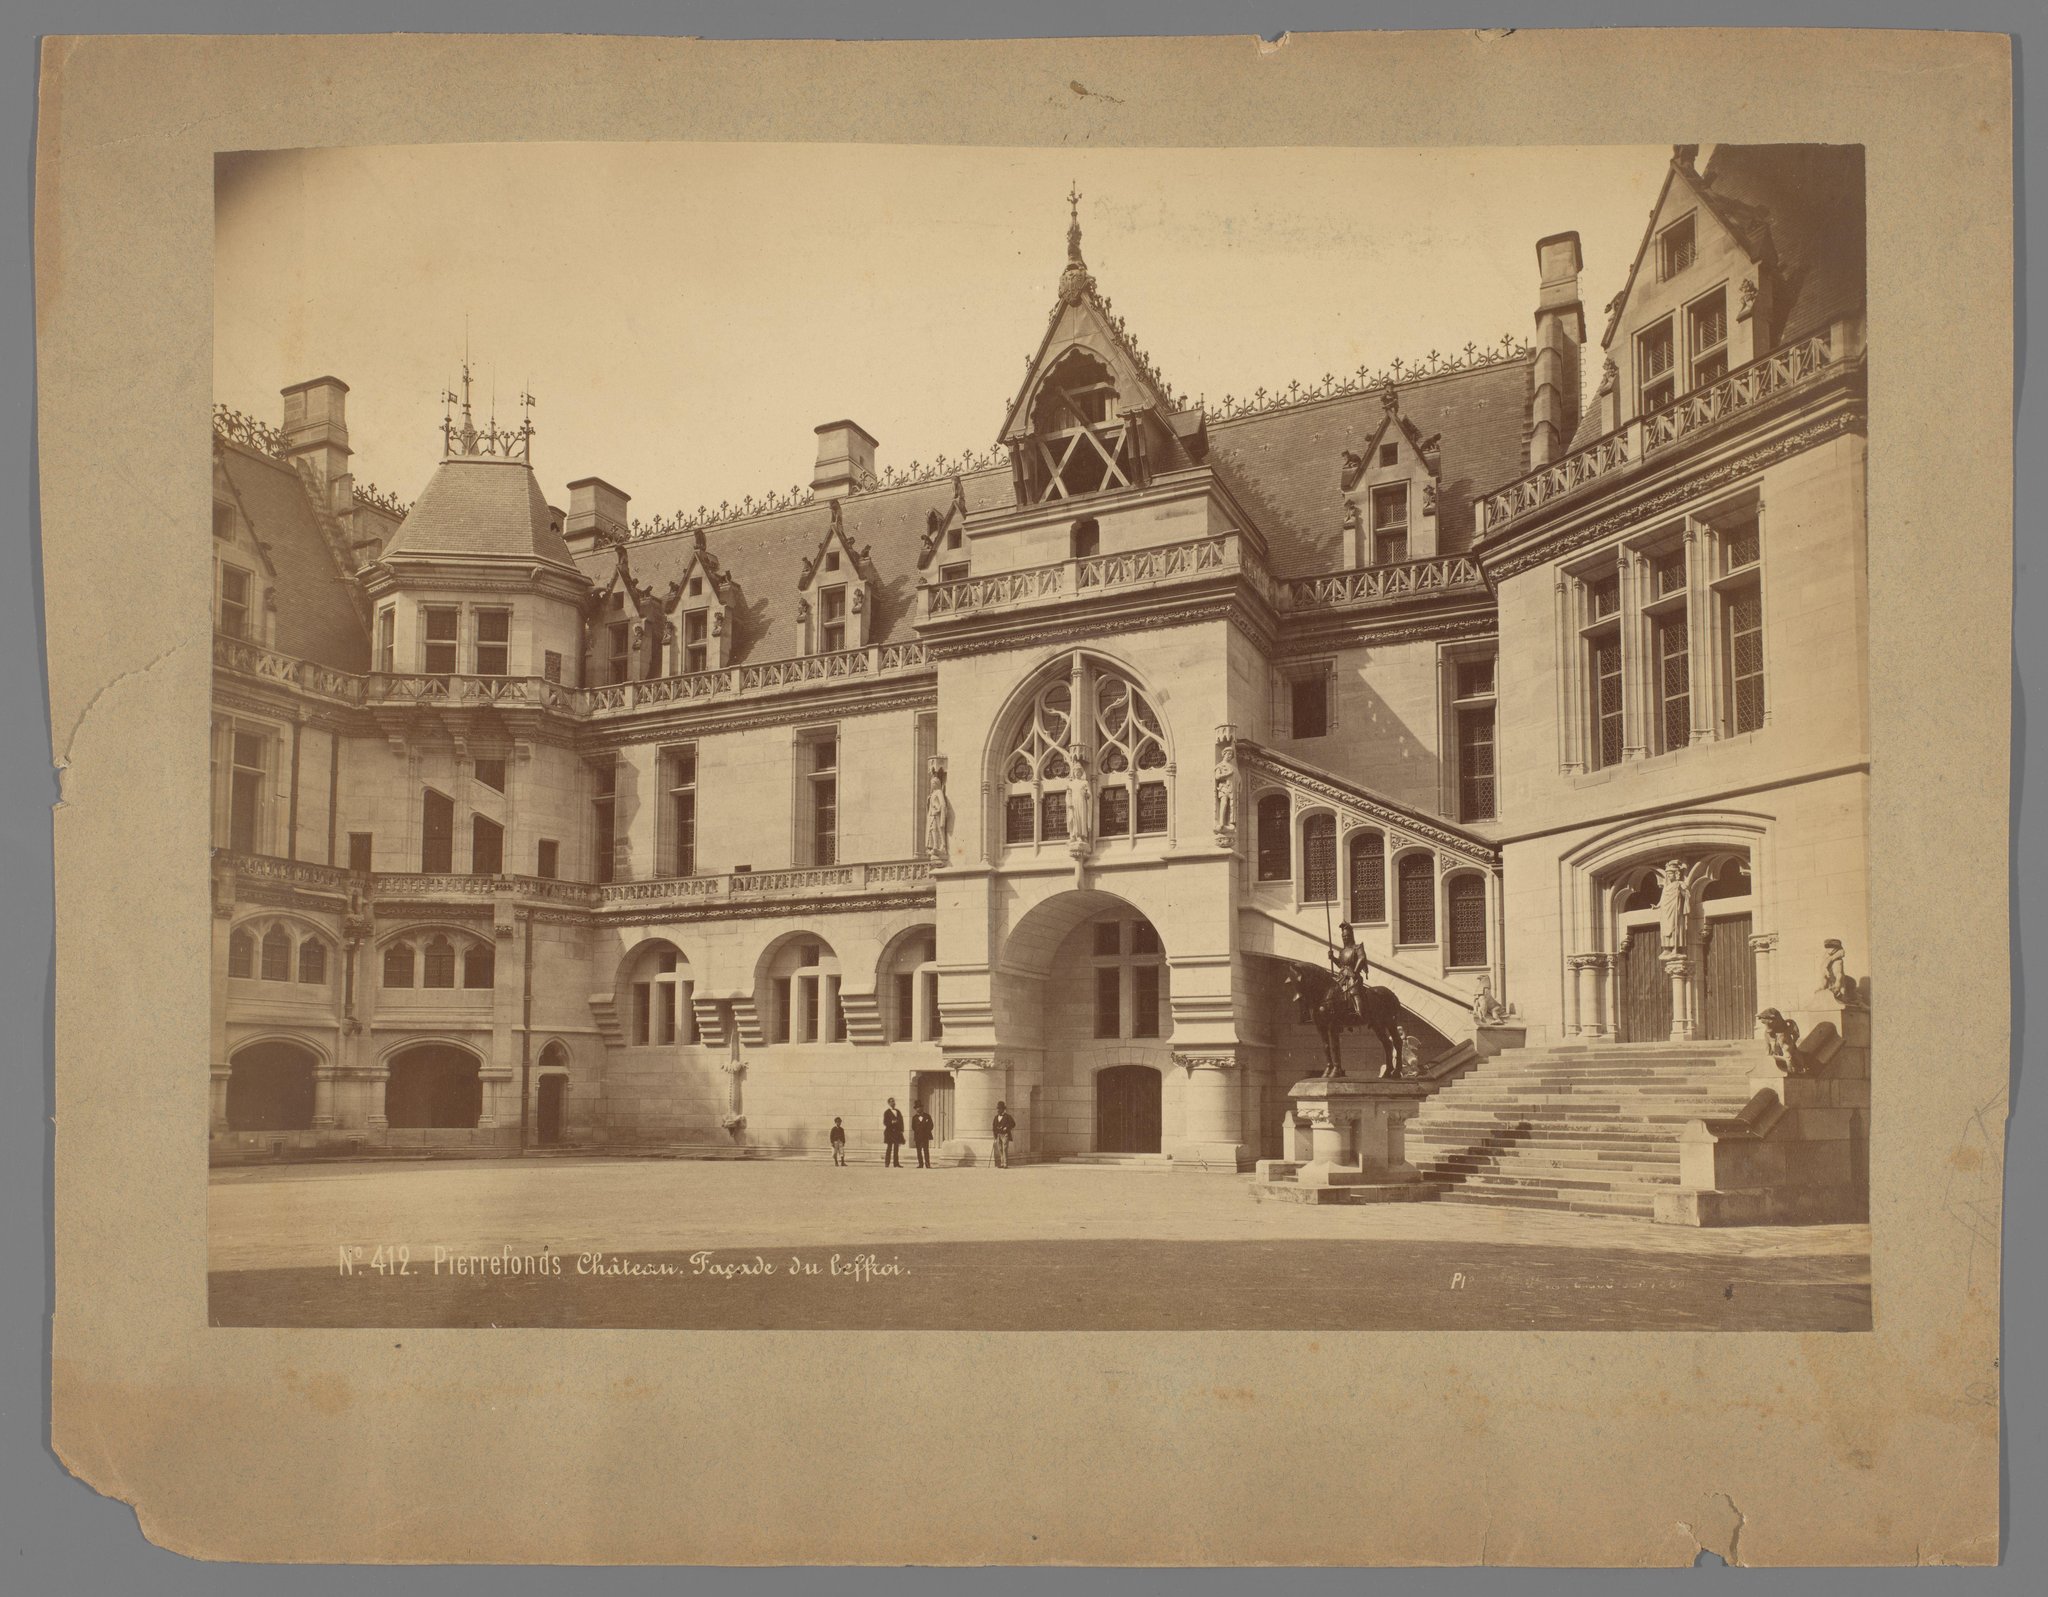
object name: photograph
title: Gezicht op de façade van het Kasteel van Pierrefonds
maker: séraphin-médéric mieusement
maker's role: fotograaf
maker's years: 1840-1905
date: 1850-1900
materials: cardboard, photographic support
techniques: albumen print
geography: pierrefonds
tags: castle, façade of inner court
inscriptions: number: ‘No. 412’, inscription: ‘Pl[...]’, collector's mark: ‘Rijks-normaalschool voor teekenonderwijzers Amsterdam’